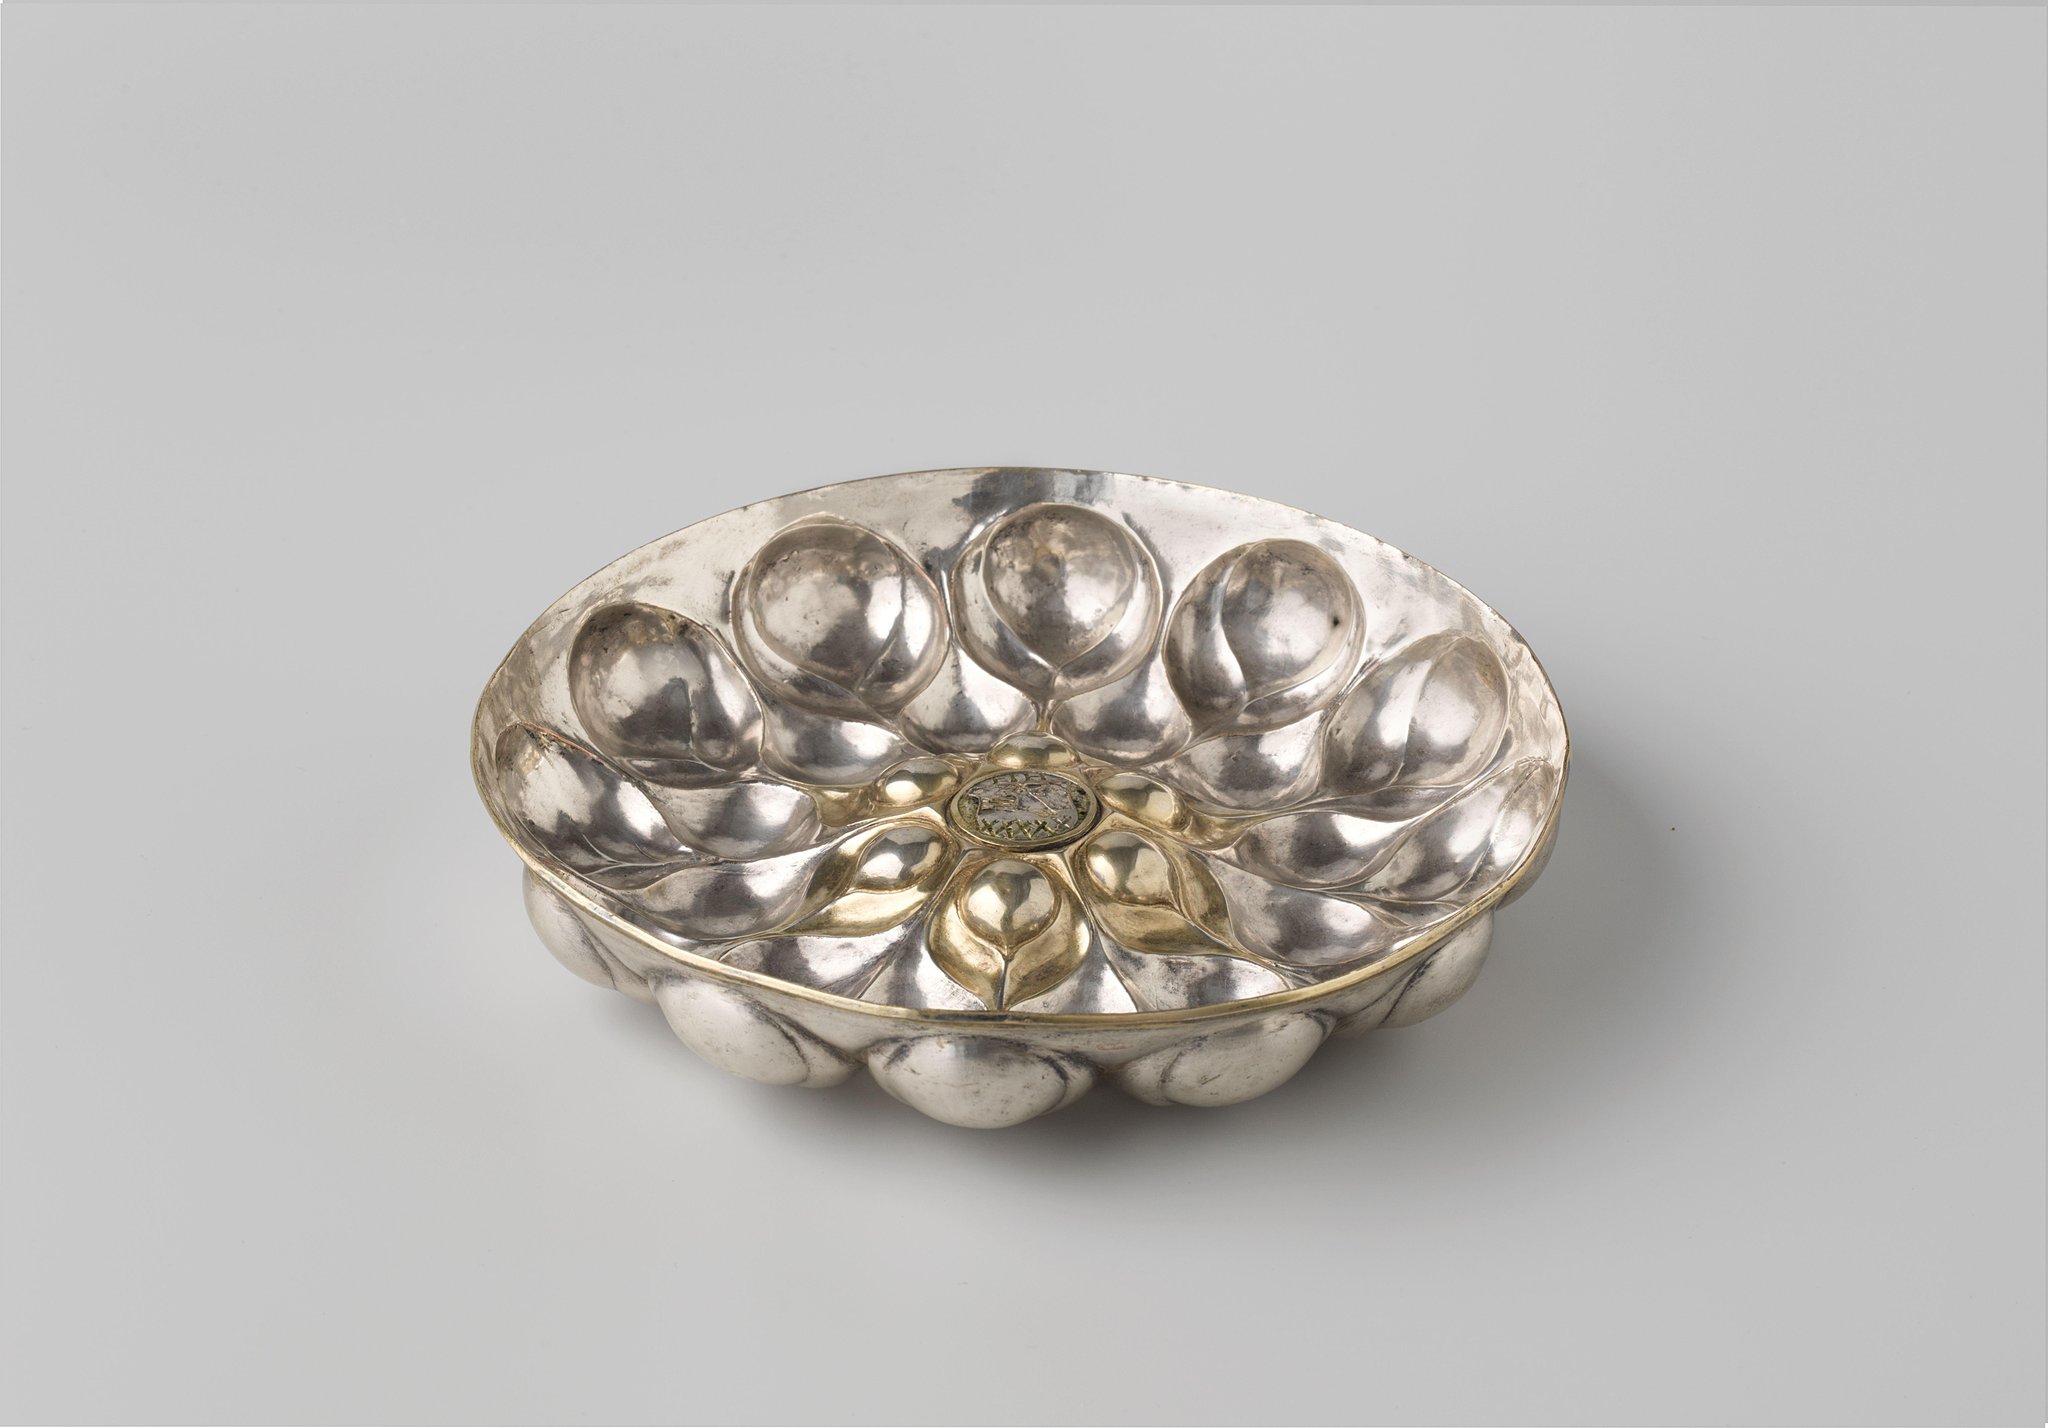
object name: dish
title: Galvanoplastische reproductie van een schaal met visblaasvormige zwellingen uit het Lüneburger Ratssilber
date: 1881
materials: copper, silver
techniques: gilding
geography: lübeck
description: Galvanoplastische reproductie van een schaal van zilver en gedeeltelijk verguld met visblaasvormige zwellingen. In het midden een wapen in kleuren.